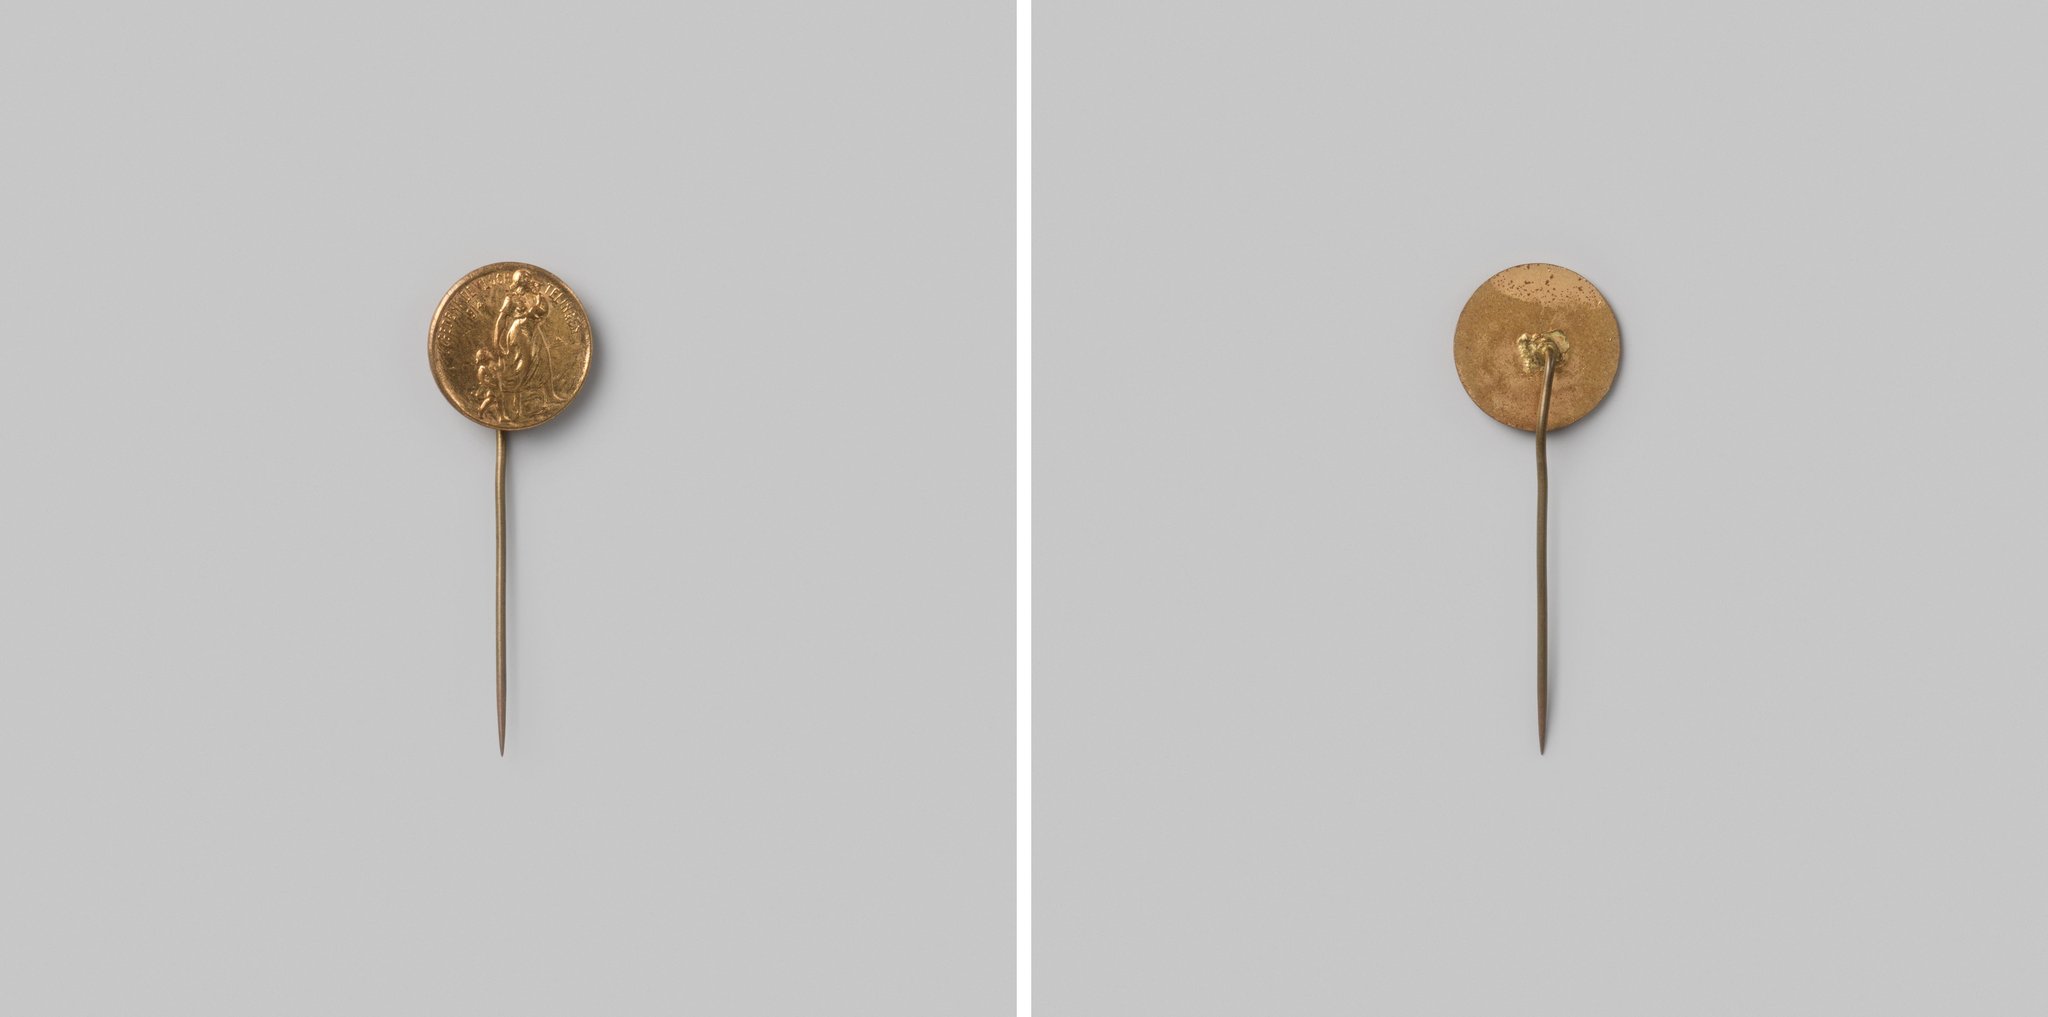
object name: insignia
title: Ondersteuning van de Belgische vluchtelingen in Nederland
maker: Anonymous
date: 1914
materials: copper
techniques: gilding, soldering, striking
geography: netherlands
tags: netherlands, belgium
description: Eenzijdig koperen plaatje, waaraan speld is gesoldeerd. Voorzijde: lopende vrouw met kind aan arm binnen omschrift. Keerzijde: blanco.